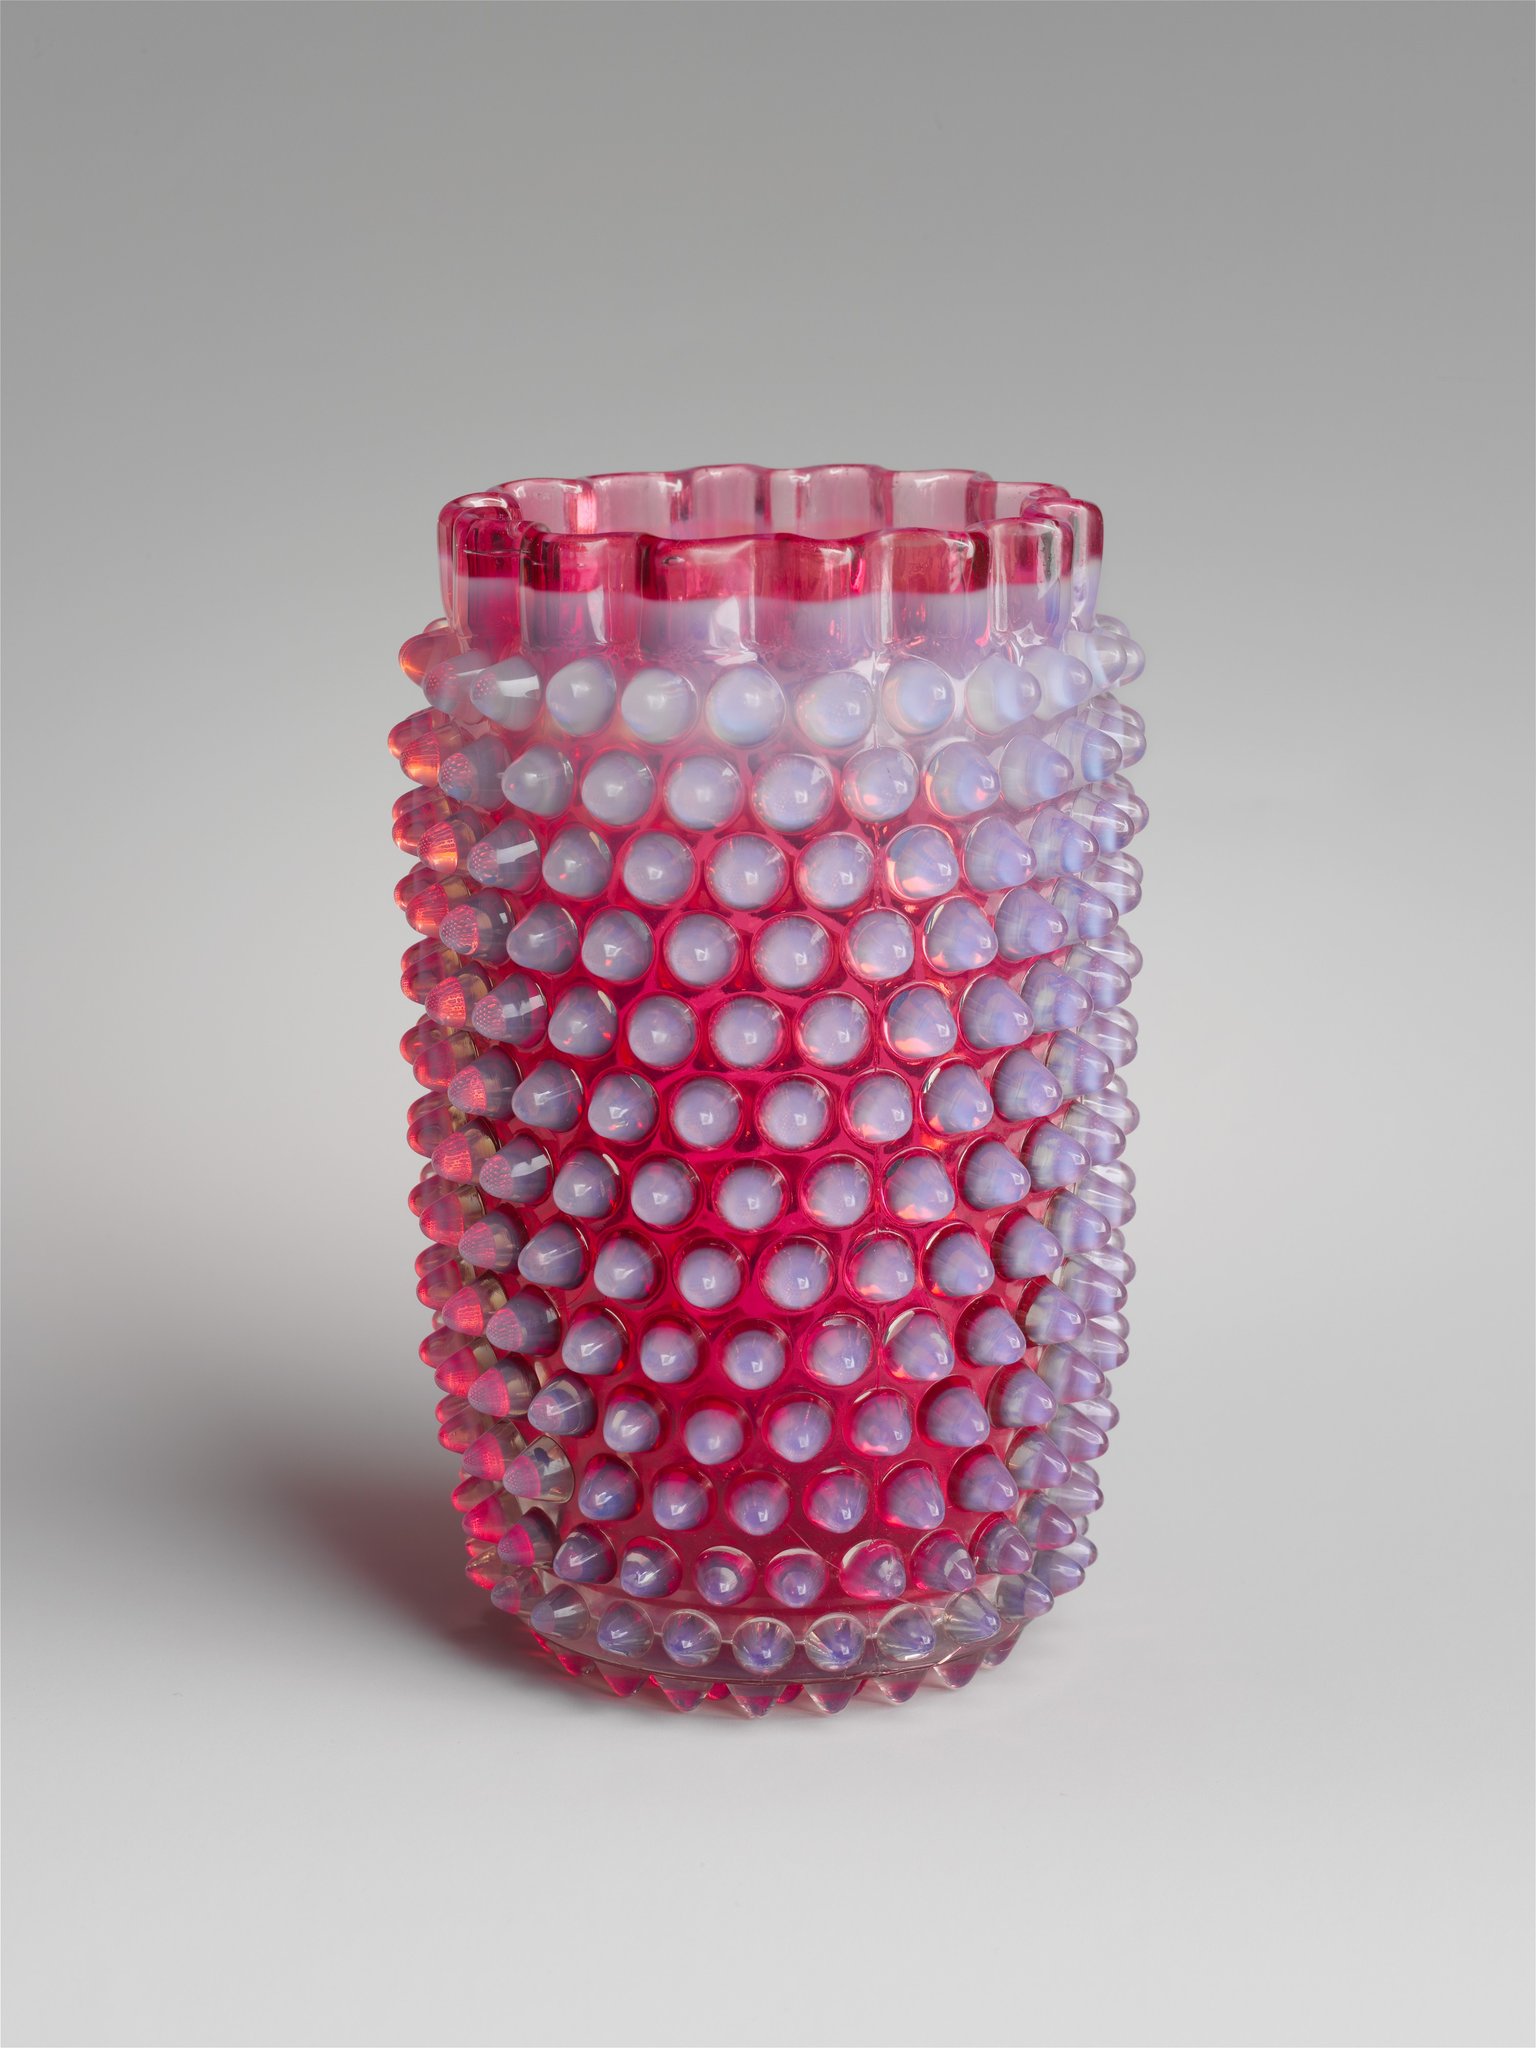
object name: celery vase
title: Hobnail Celery vase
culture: american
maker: hobbs, brockunier and company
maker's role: maker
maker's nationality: american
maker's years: 1863-1891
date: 1886-1900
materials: glass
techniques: pressed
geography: united states